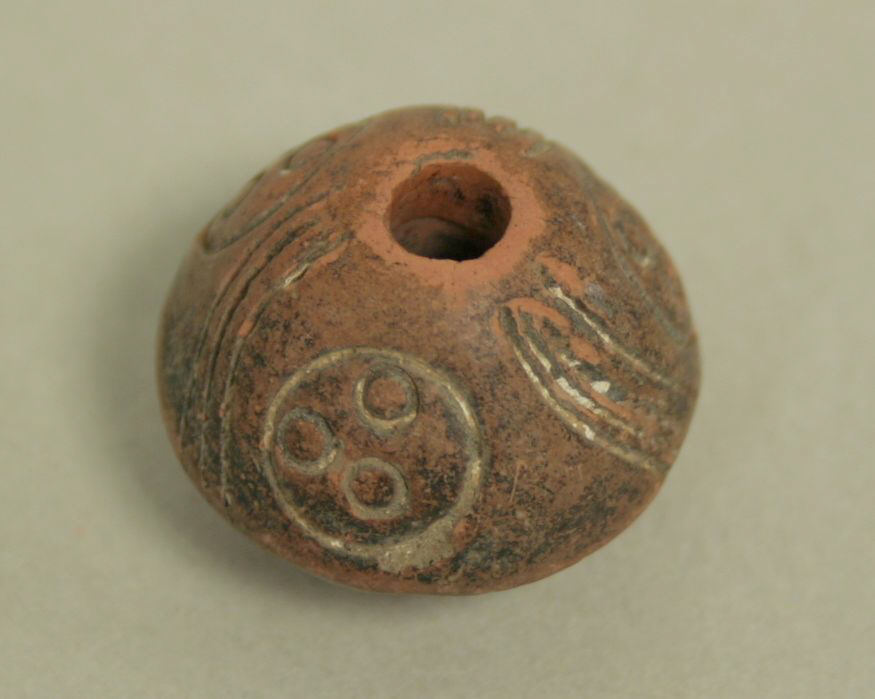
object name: spindle whorl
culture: peruvian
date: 1-500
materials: ceramic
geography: peru